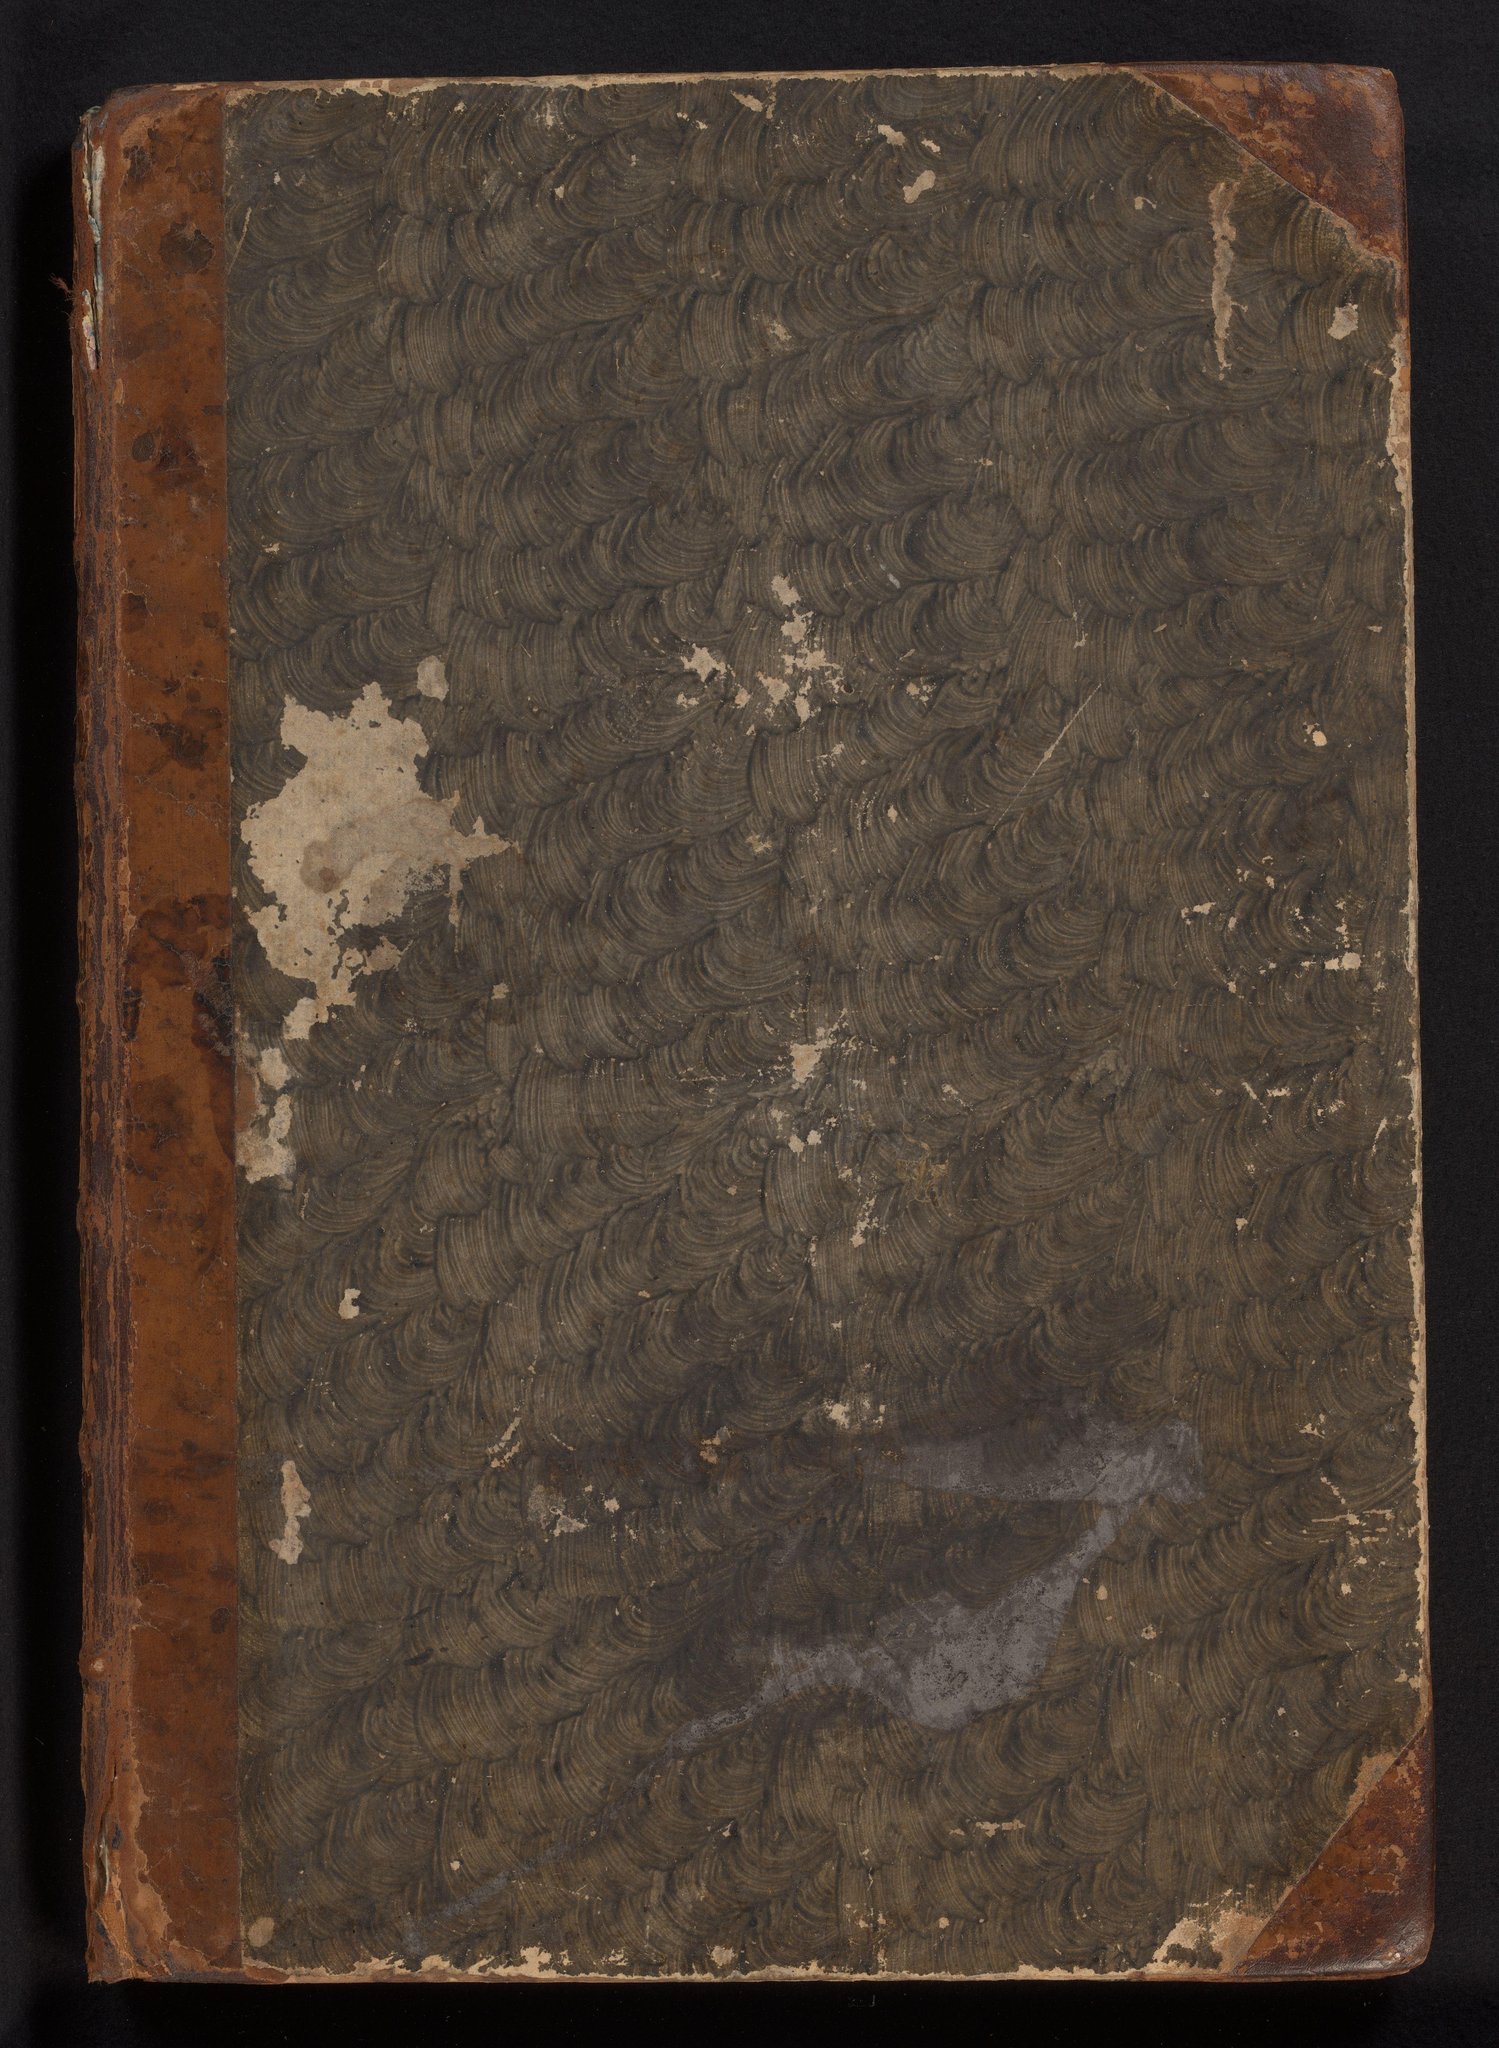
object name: prentrecueil, prentenalbum, prentalbum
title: Album met prenten naar tekeningen van diverse onderwerpen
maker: carl friedrich holtzmann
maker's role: print maker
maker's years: 1740-1811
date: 1789-1811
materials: cardboard, leather, paper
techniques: bookbinding, decorated paper, etching, intaglio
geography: dresden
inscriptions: collector's mark: Lugt 2228, collector's mark: Lugt 2760, stamp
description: Album met een titelprent en 52 etsen op 29 albumbladen. De voorstellingen zijn gemaakt naar tekeningen door onder andere Christian Wilhelm Ernst Dietrich, Johann Georg Wagner, Salvator Rosa en François Perrier. Ze hebben landschappen, portretten en alledaagse taferelen als onderwerp. Op de albumbladen zijn vaak meerdere voorstellingen gedrukt.